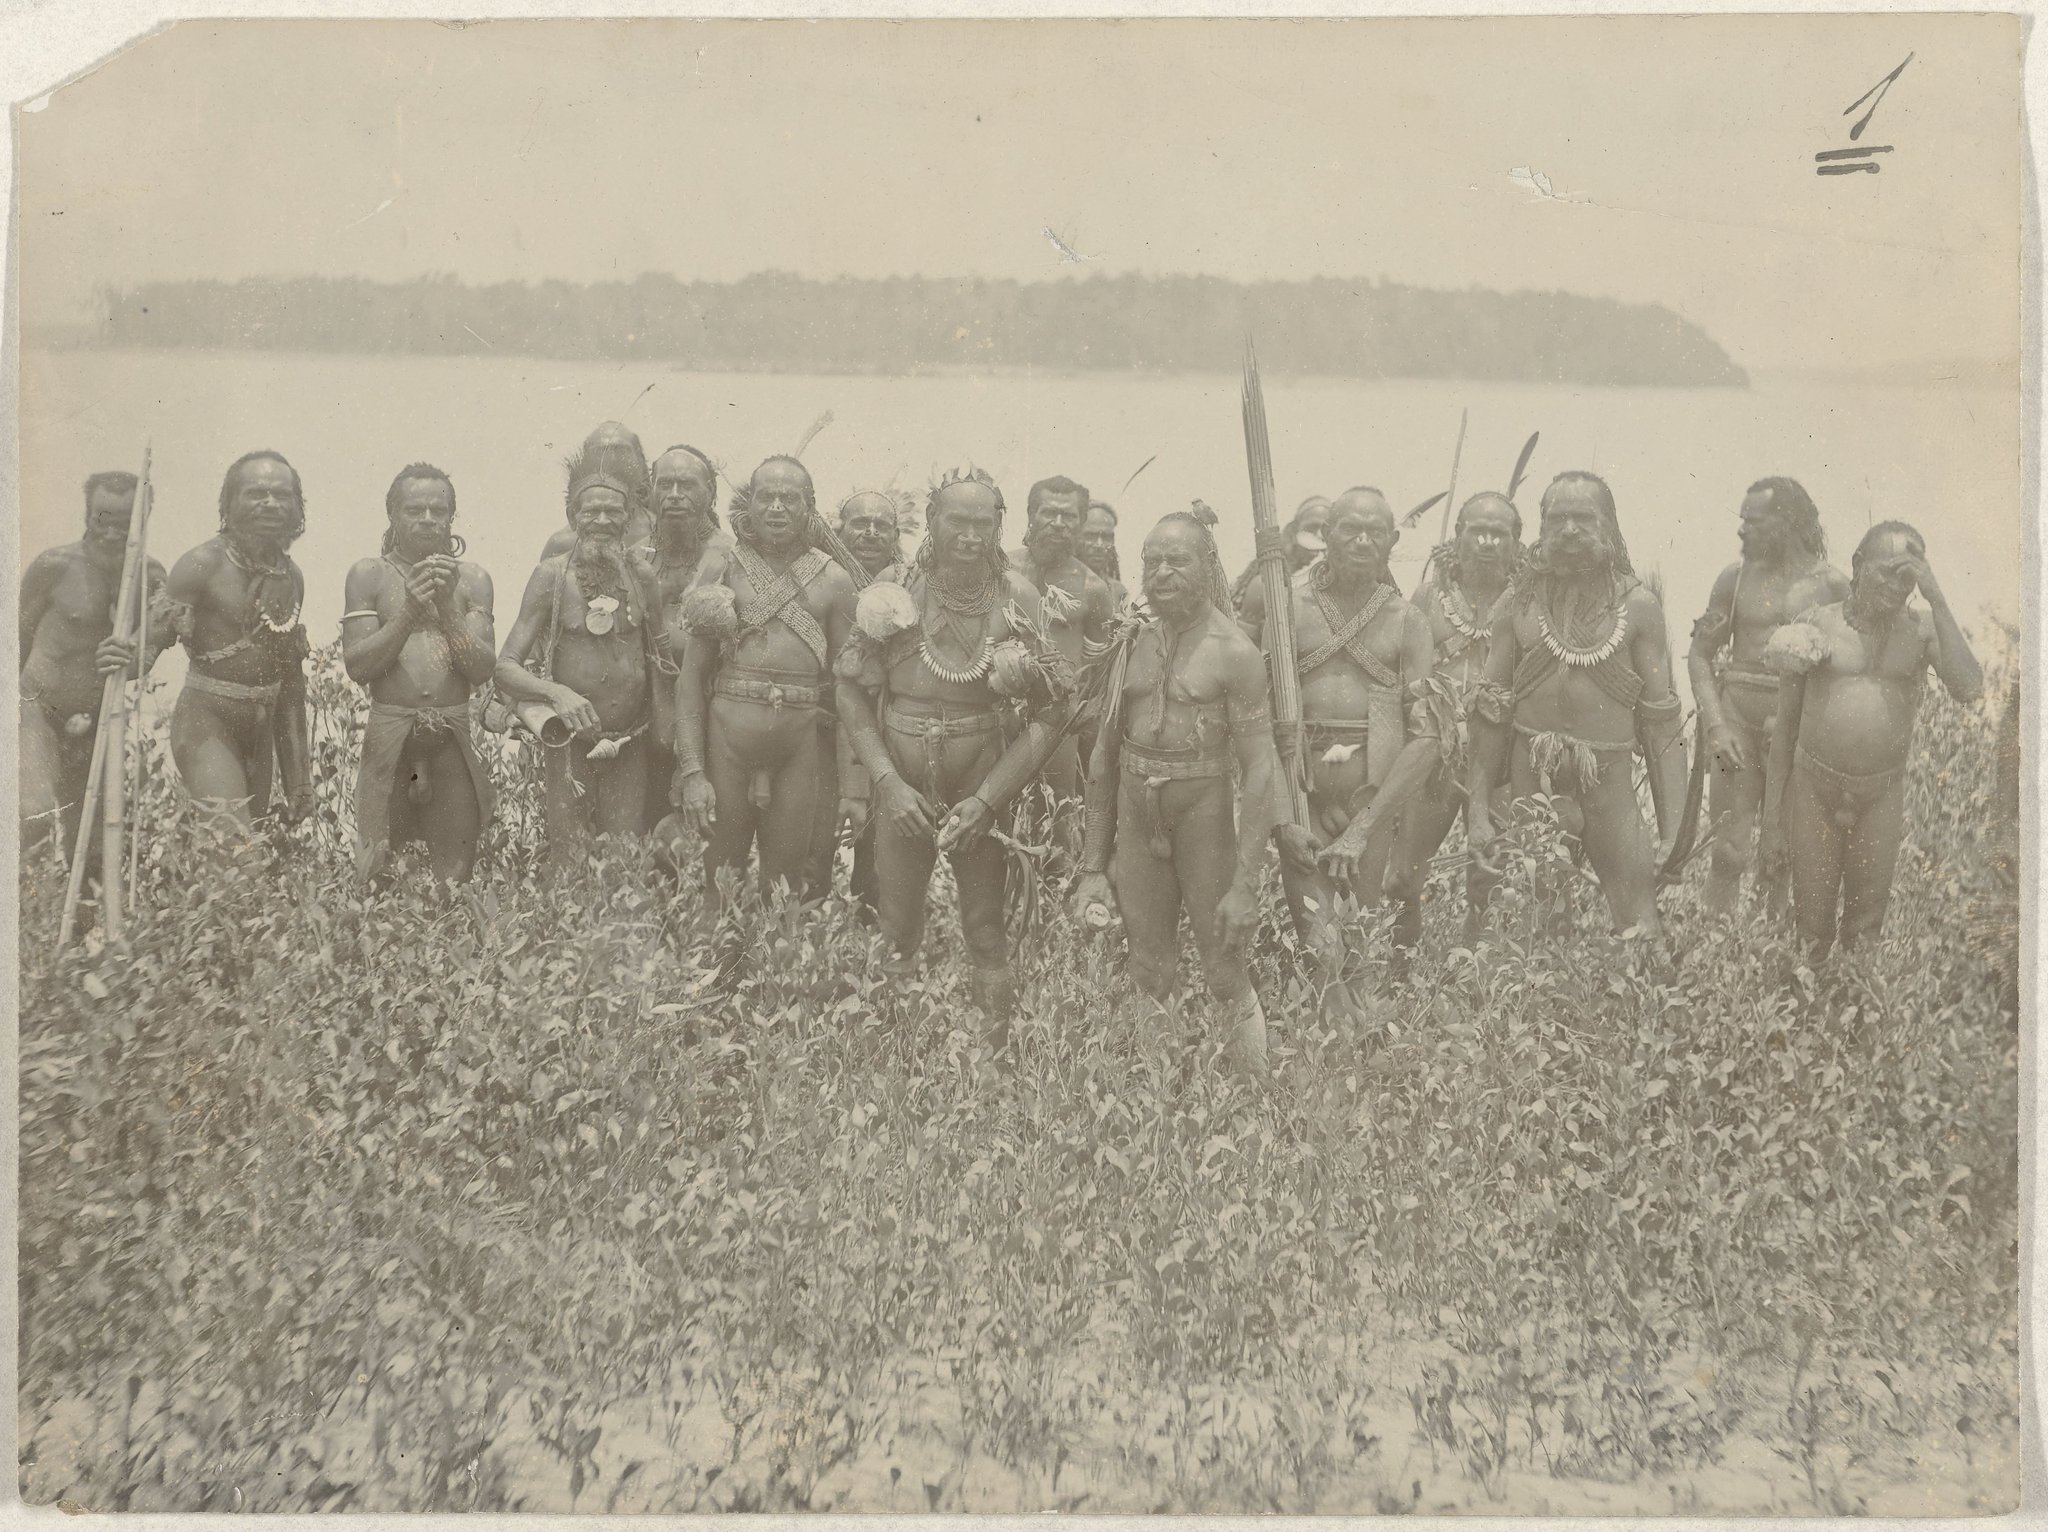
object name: photograph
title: Groepsportret van achttien onbekende Papoea's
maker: Anonymous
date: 1880-1910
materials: paper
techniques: gelatin silver print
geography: nieuw-guinea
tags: island, adult man, anonymous historical persons portrayed in a group, in a group-portrait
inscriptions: inscription: ‘Papoeas’